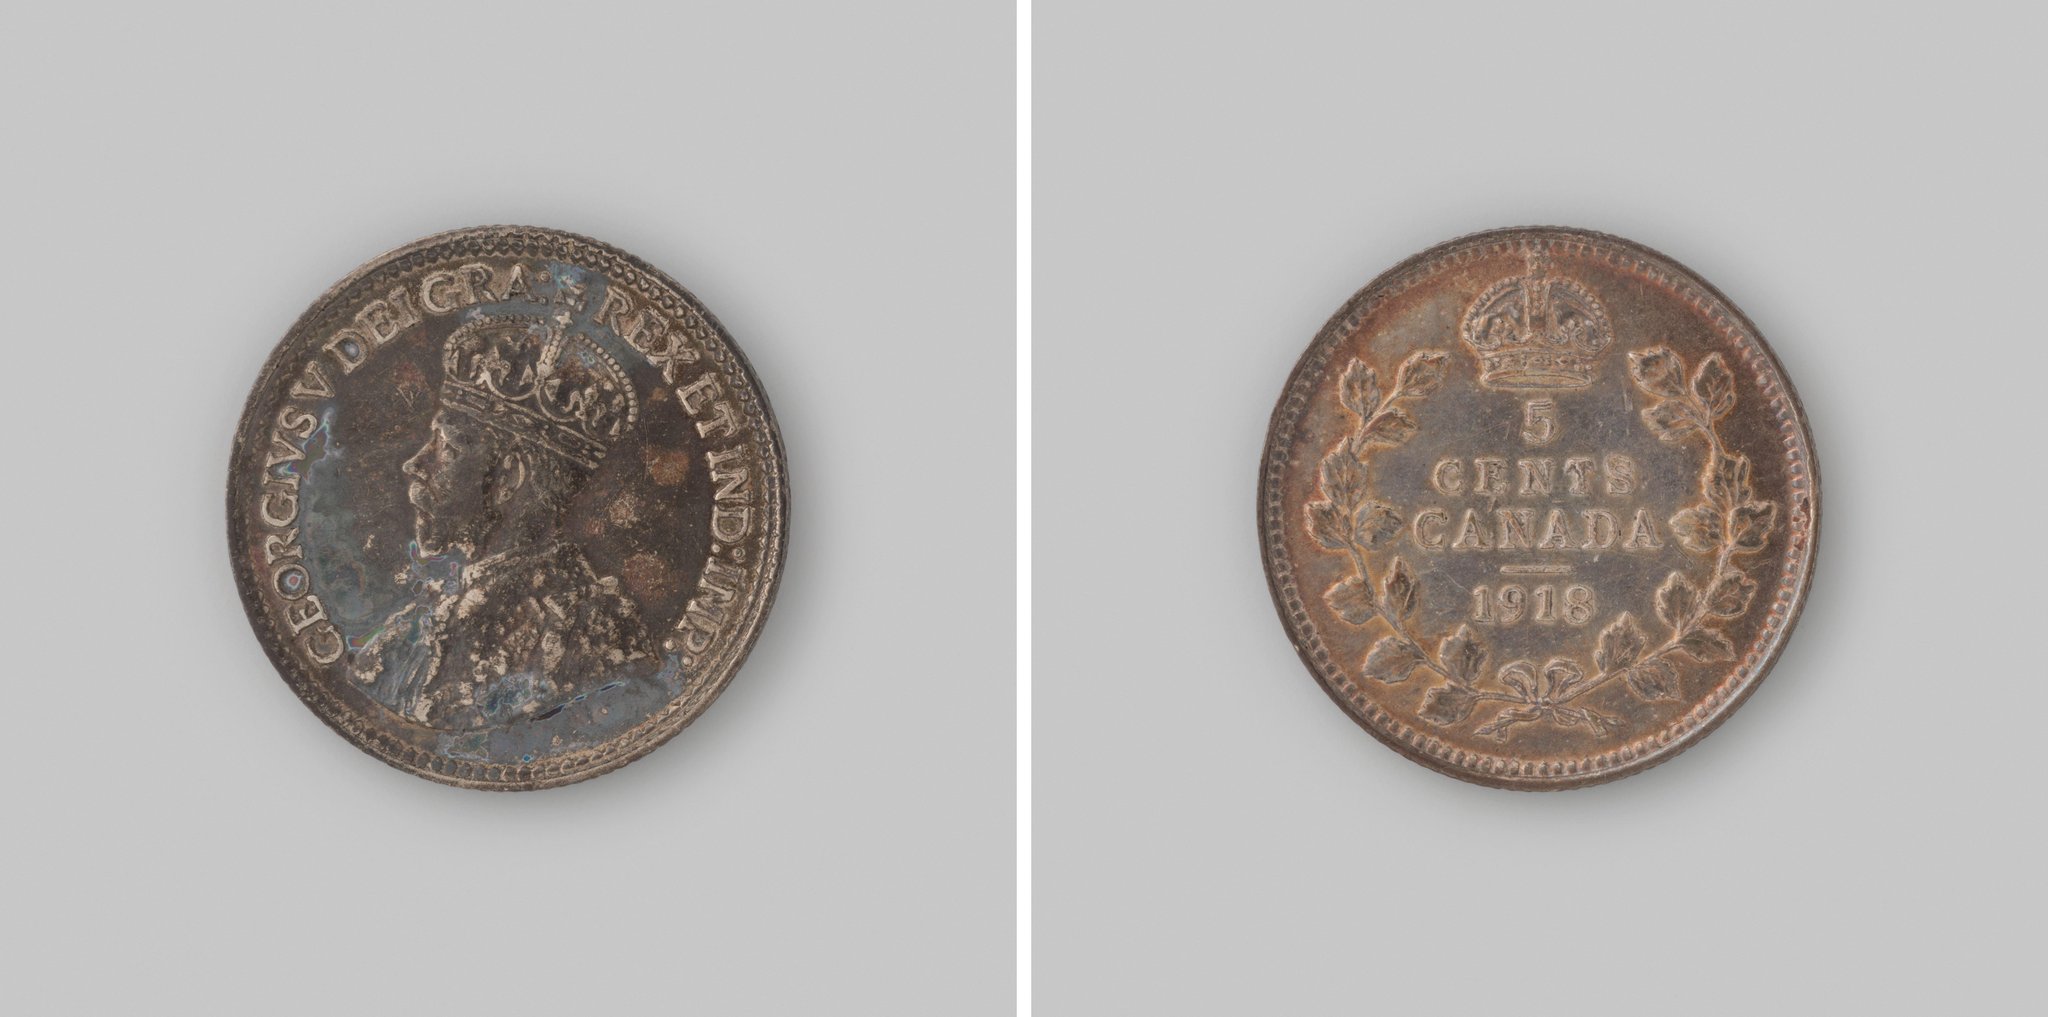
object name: coin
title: 5 cents uit Canada, 1918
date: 1918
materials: silver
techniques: striking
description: Zilveren munt. Voorzijde: gekroond borstbeeld van Georg V naar links. Keerzijde: binnen twee samengebonden takken kroon, waaronder waarde-aanduiding in twee regels. Daaronder lands-aanduiding, waaronder jaartal. Kartelrand.